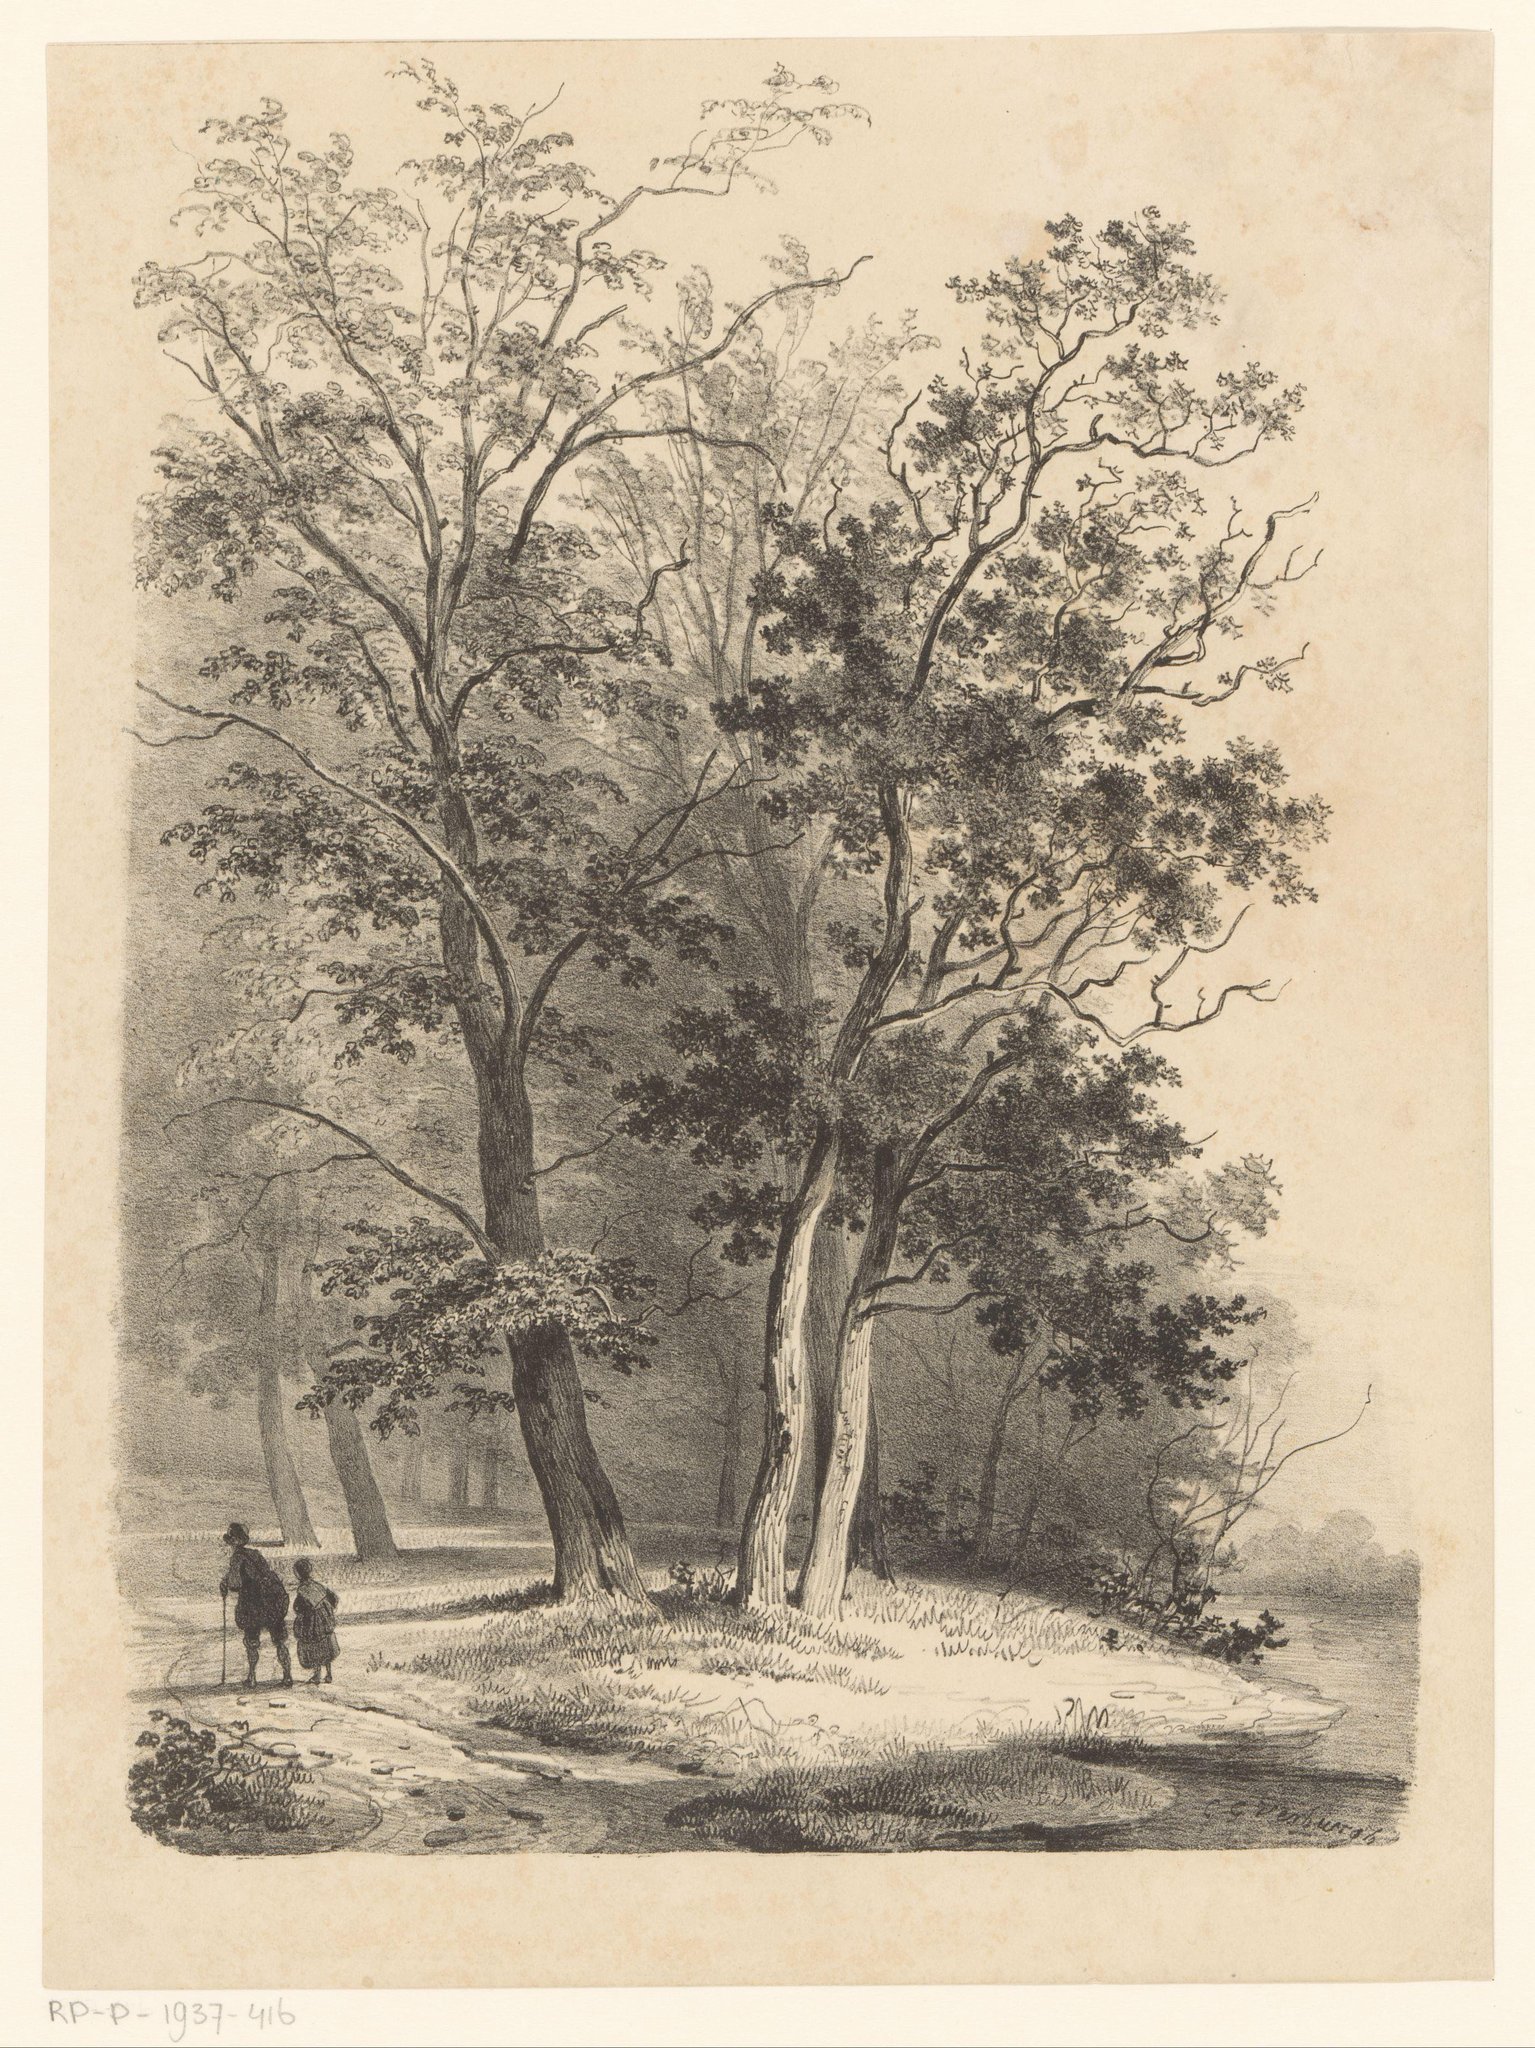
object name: print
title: Twee figuren wandelen in een bos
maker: cornelis gerrit verburgh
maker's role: print maker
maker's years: 1802-1879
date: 1812-1879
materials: paper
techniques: lithograph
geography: rotterdam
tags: forest, wood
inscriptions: collector's mark: Lugt 2760, collector's mark: Lugt 2228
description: Een man en meisje lopen in een bos met rechts een plas.